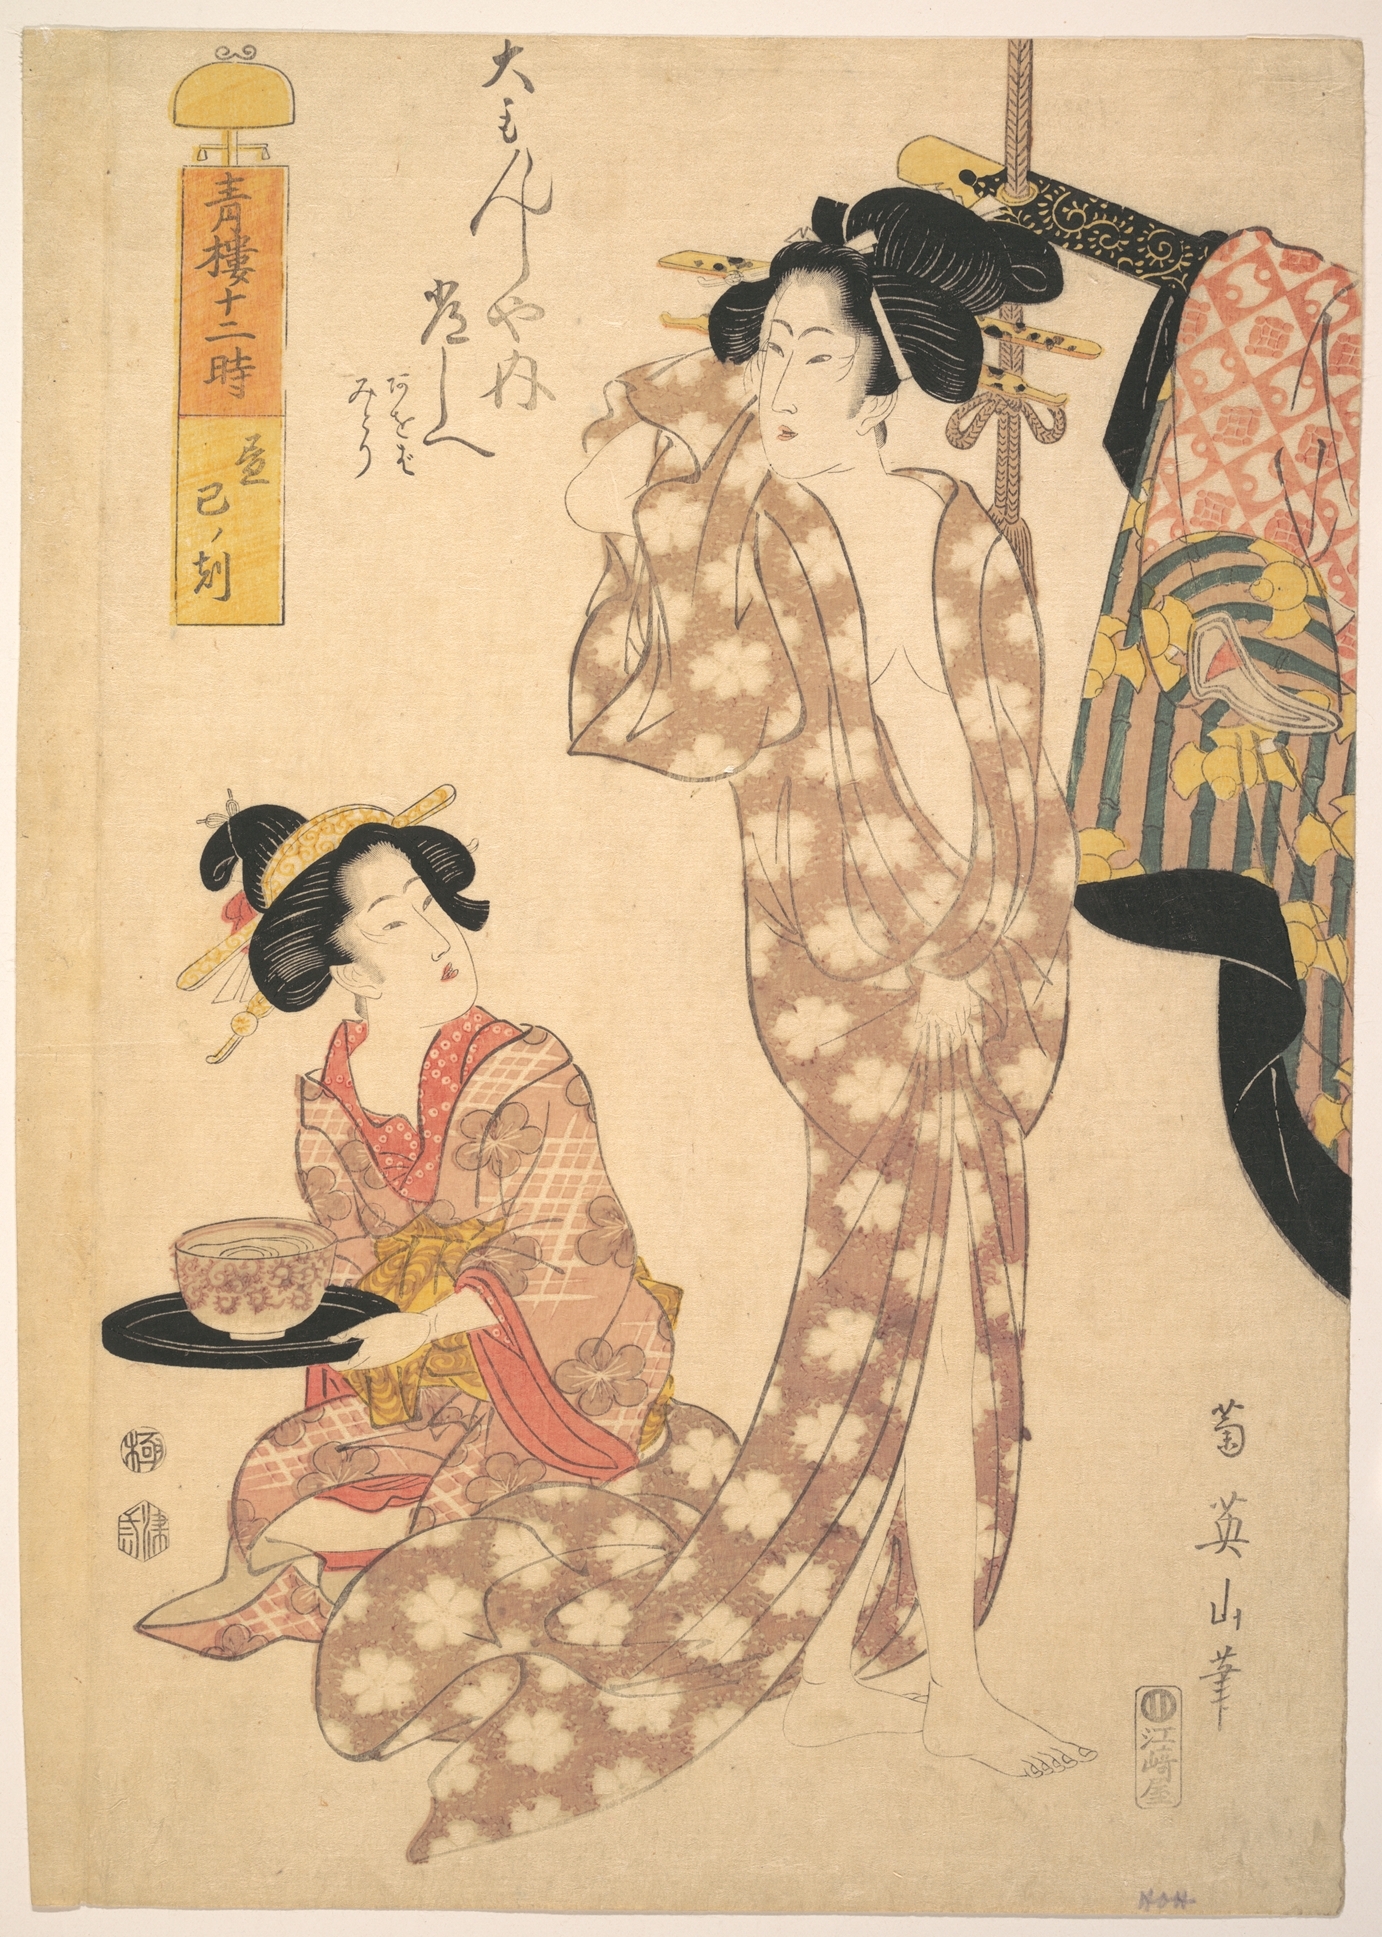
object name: print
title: Young Woman Making Her Toilet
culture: japanese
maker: kikugawa eizan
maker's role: artist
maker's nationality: japanese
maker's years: 1787-1867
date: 1787-1867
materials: ink, paper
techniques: woodblock print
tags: women